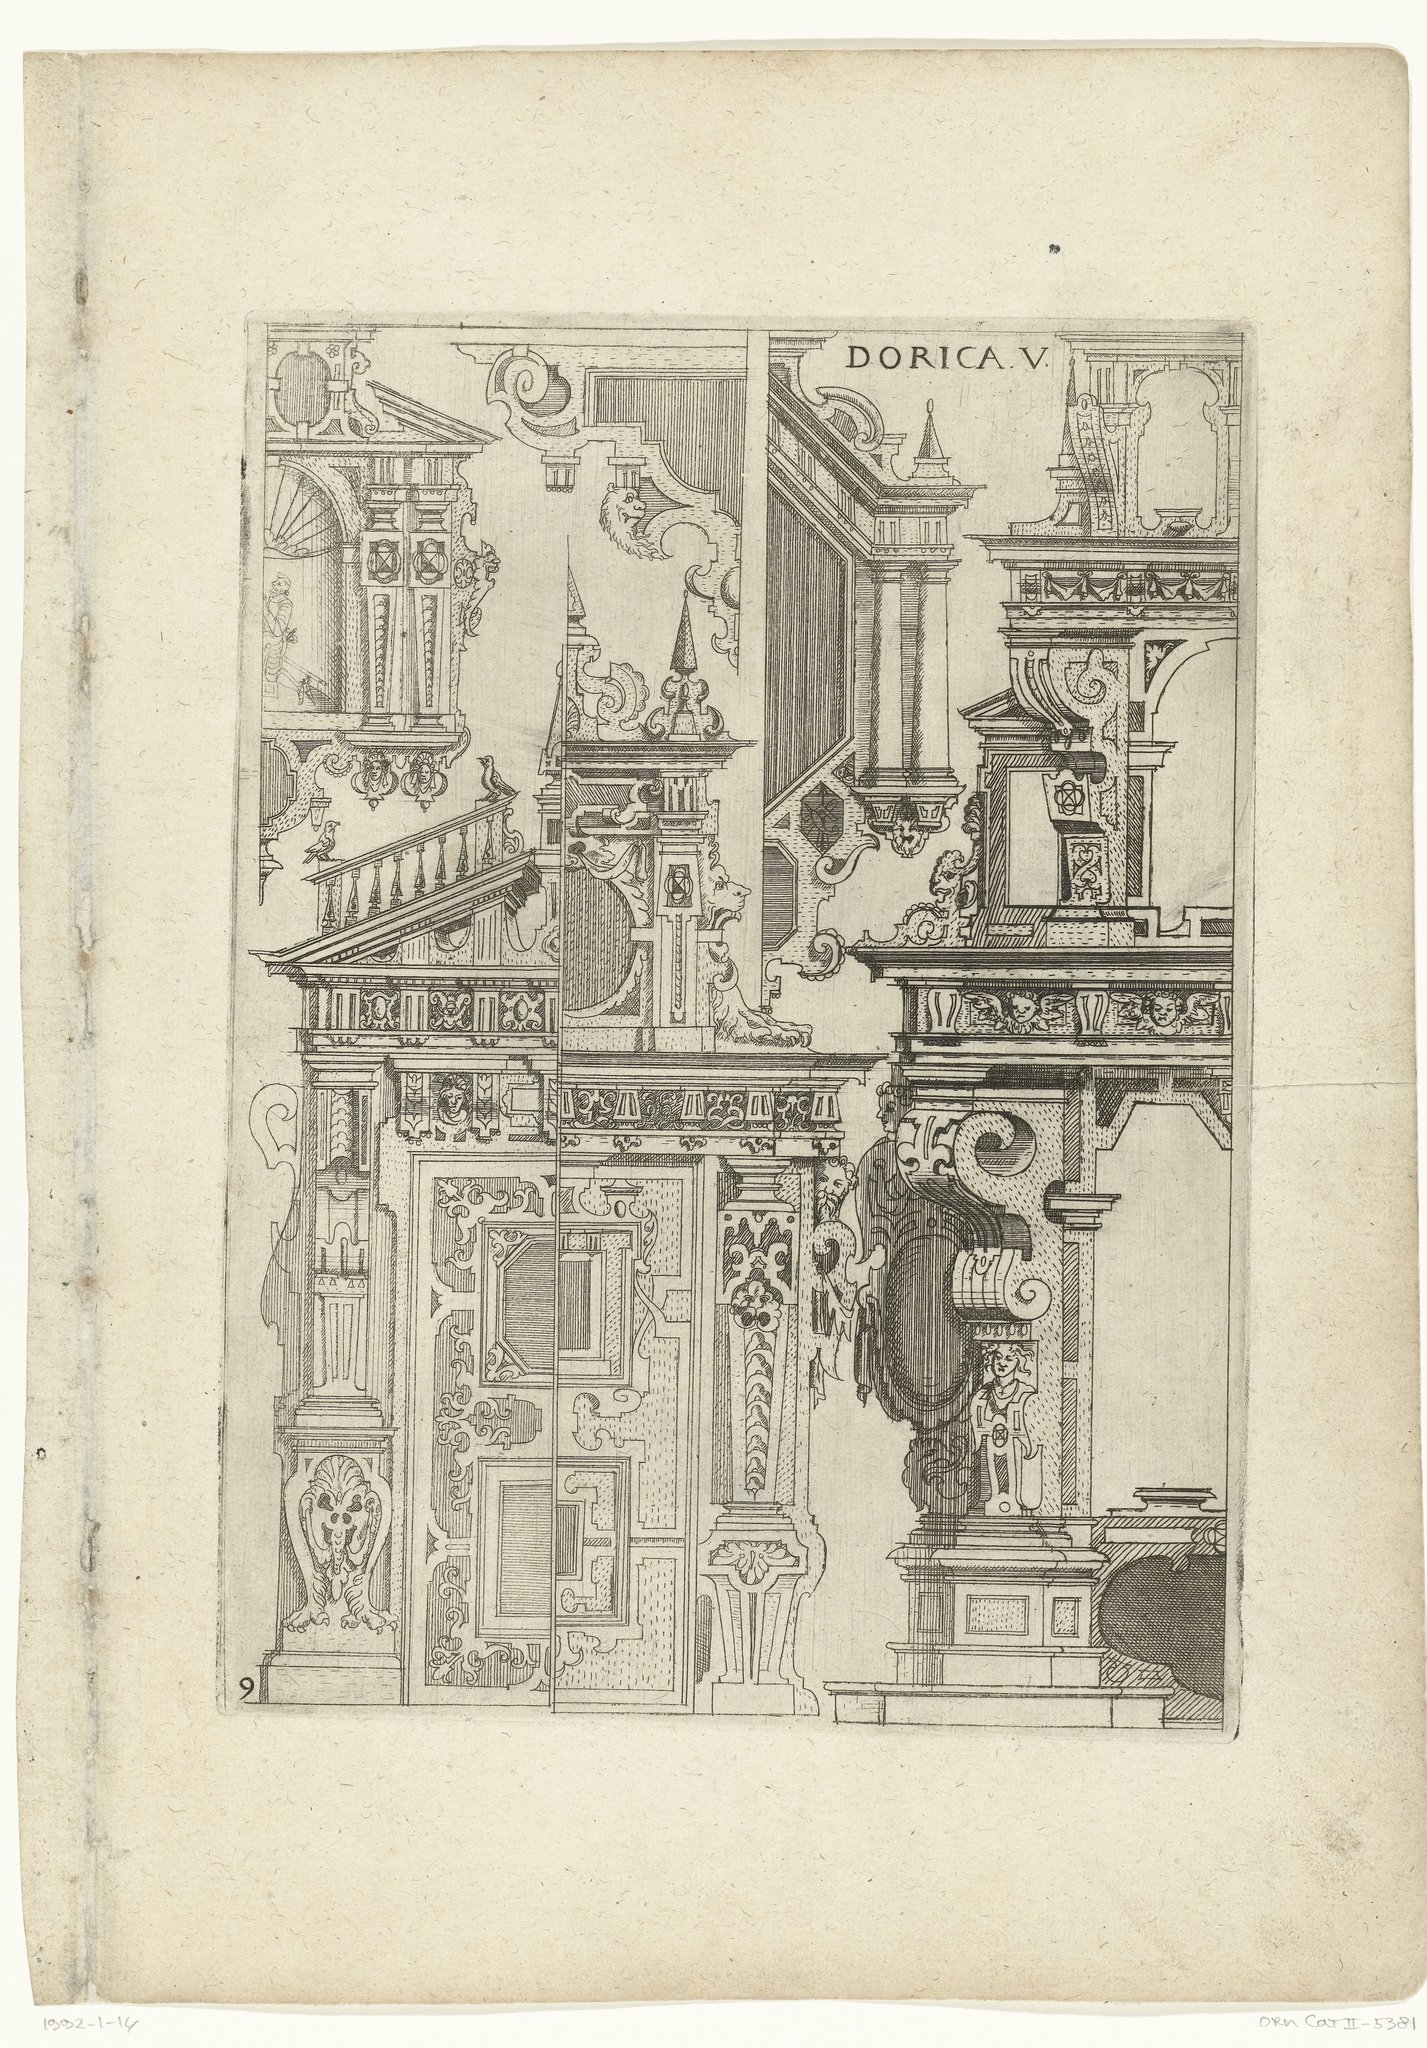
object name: print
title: Architectura von den funf Seuvlen (...)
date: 1610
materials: paper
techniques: etching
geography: germany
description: Blad 9 uit serie van titelblad en 28 bladen.